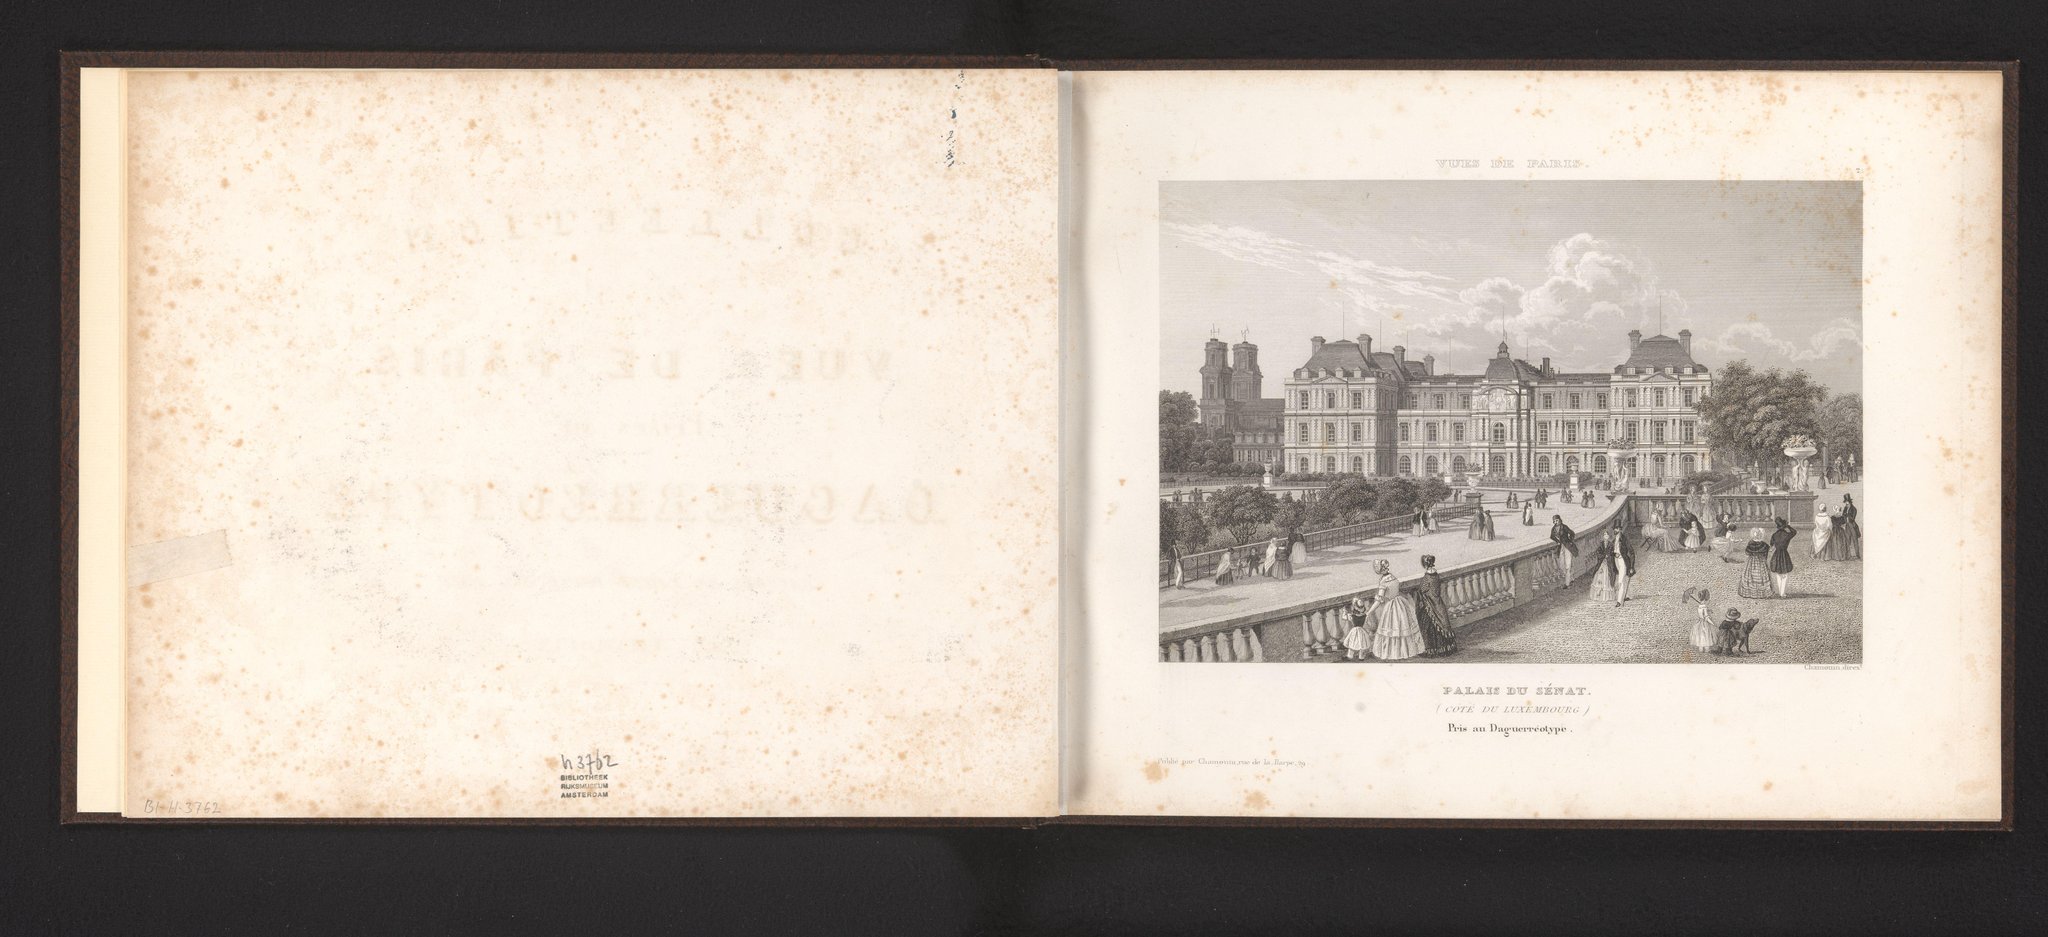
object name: page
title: Vues de Paris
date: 1845-1850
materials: paper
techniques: engraving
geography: paris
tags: palace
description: Prent op eerste ongenummerde pagina na titelpagina. Prent gemaakt naar daguerreotypie.